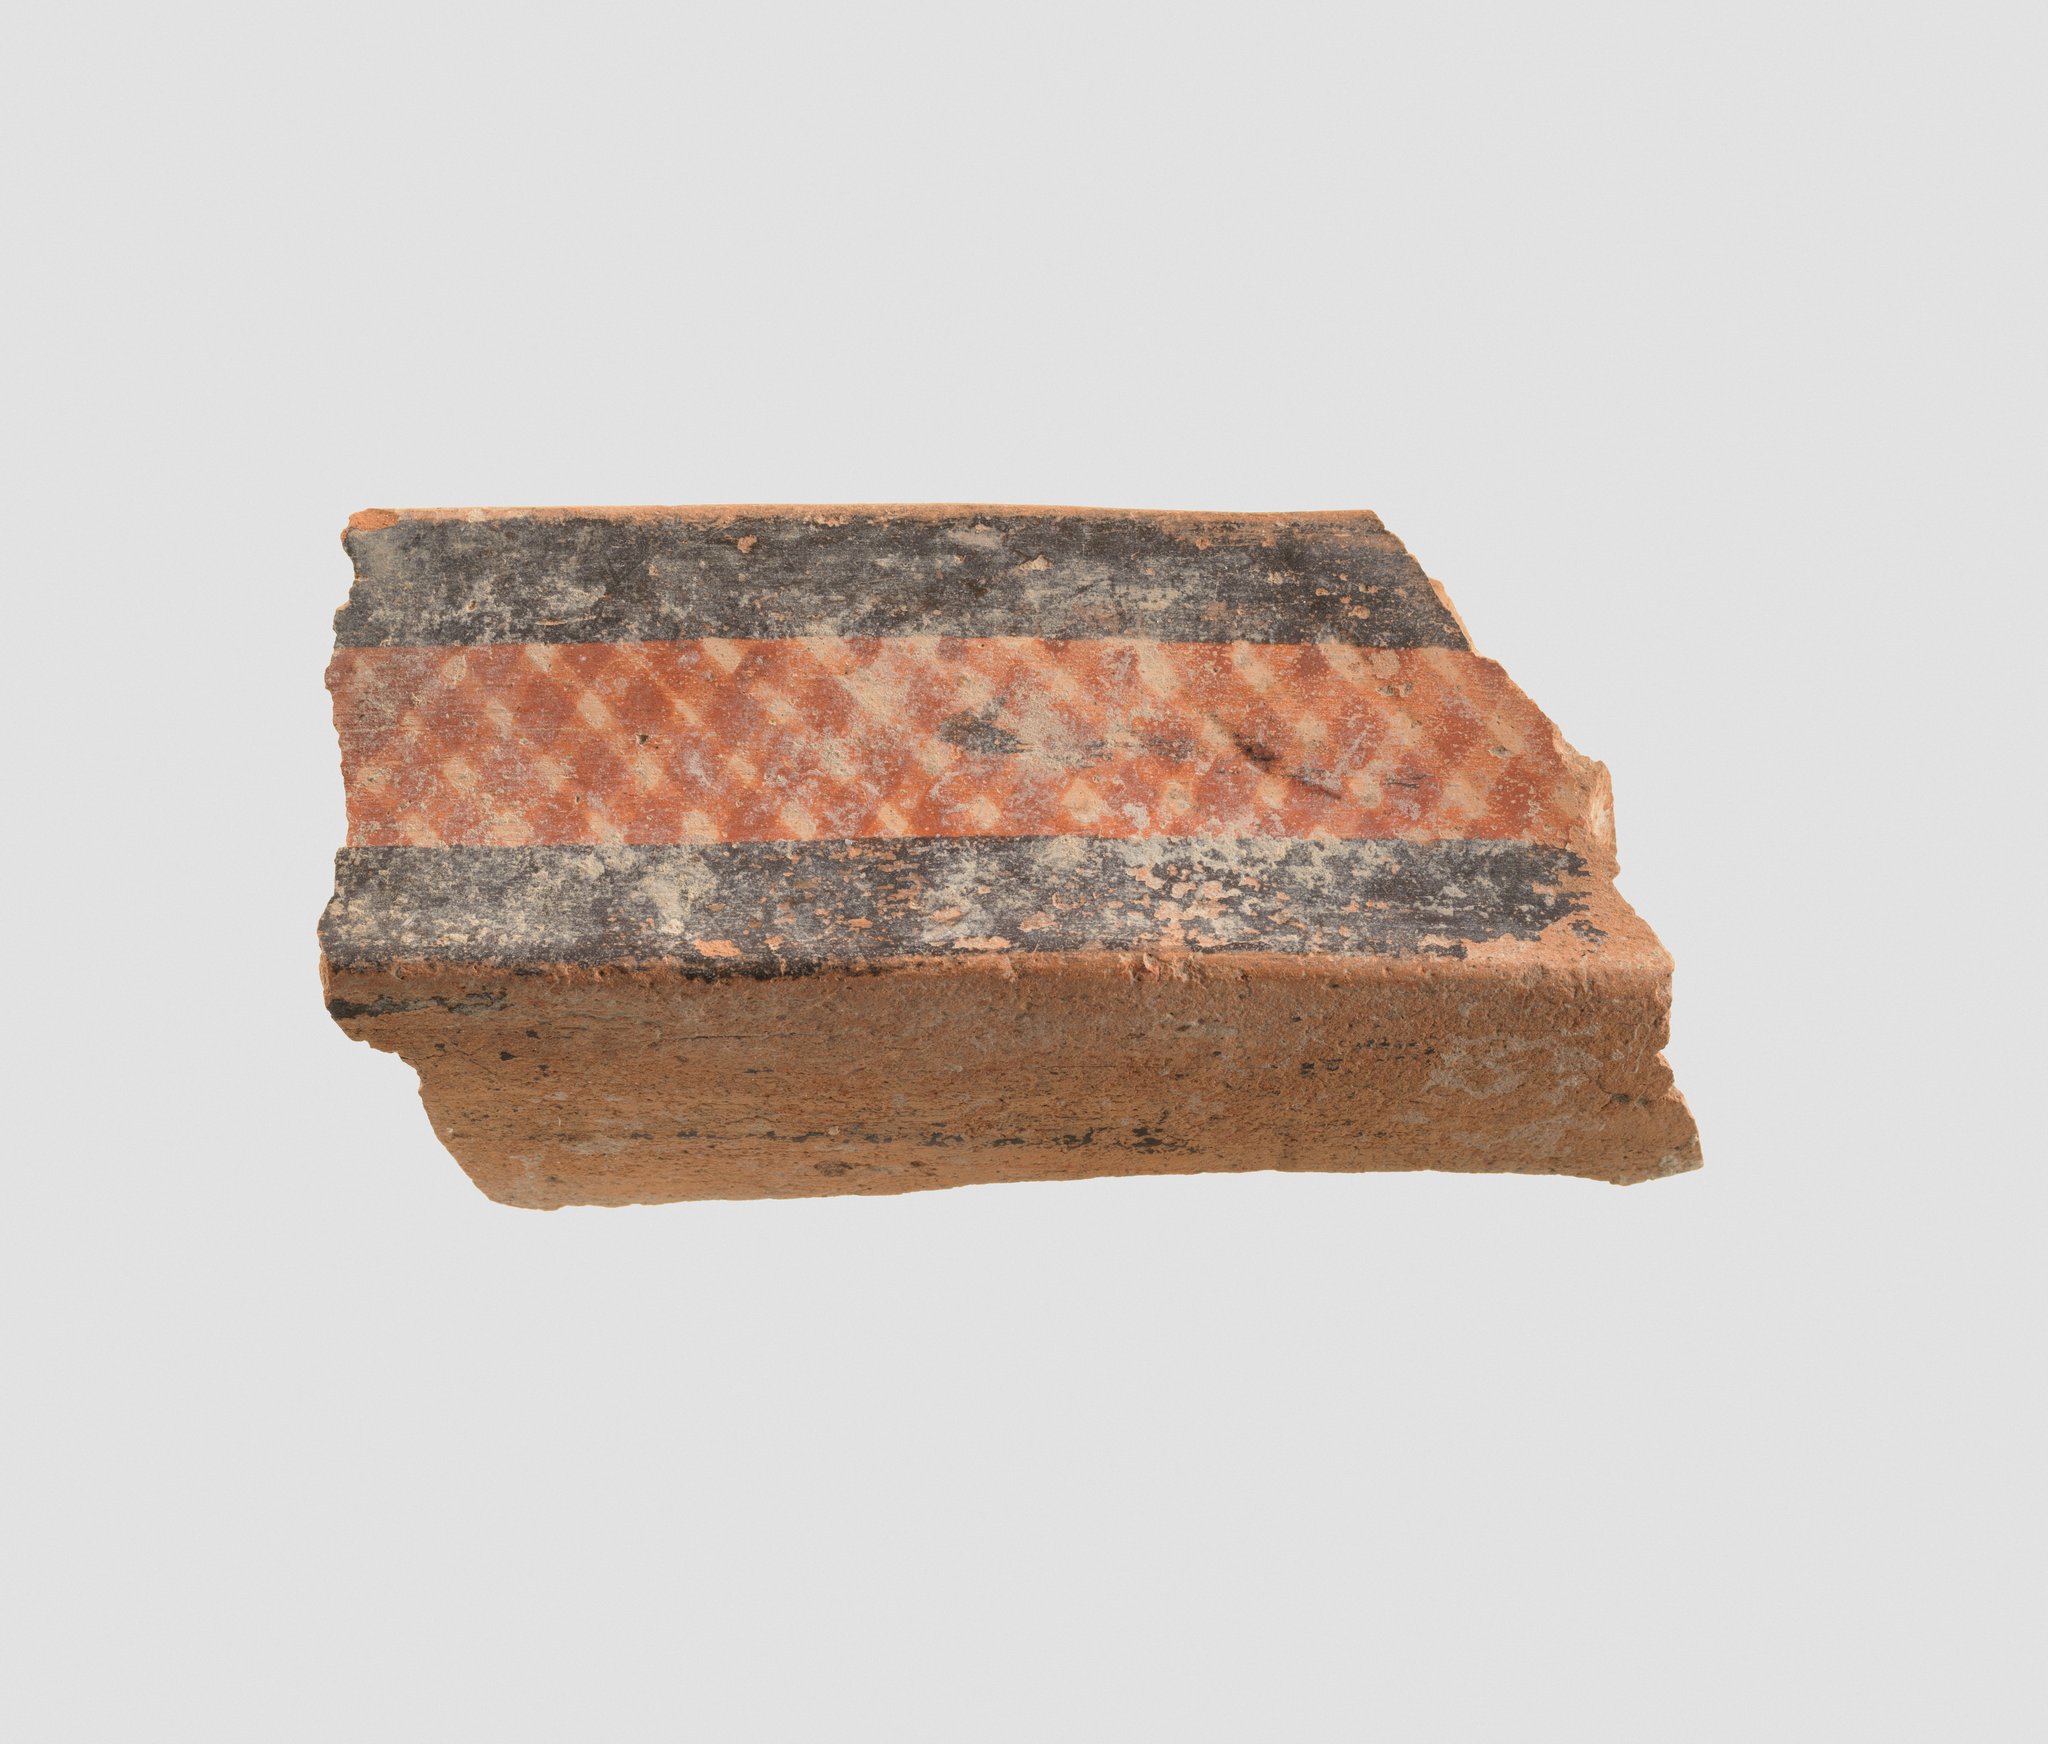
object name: sherd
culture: halaf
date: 5000-4500 BCE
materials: ceramic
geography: syria